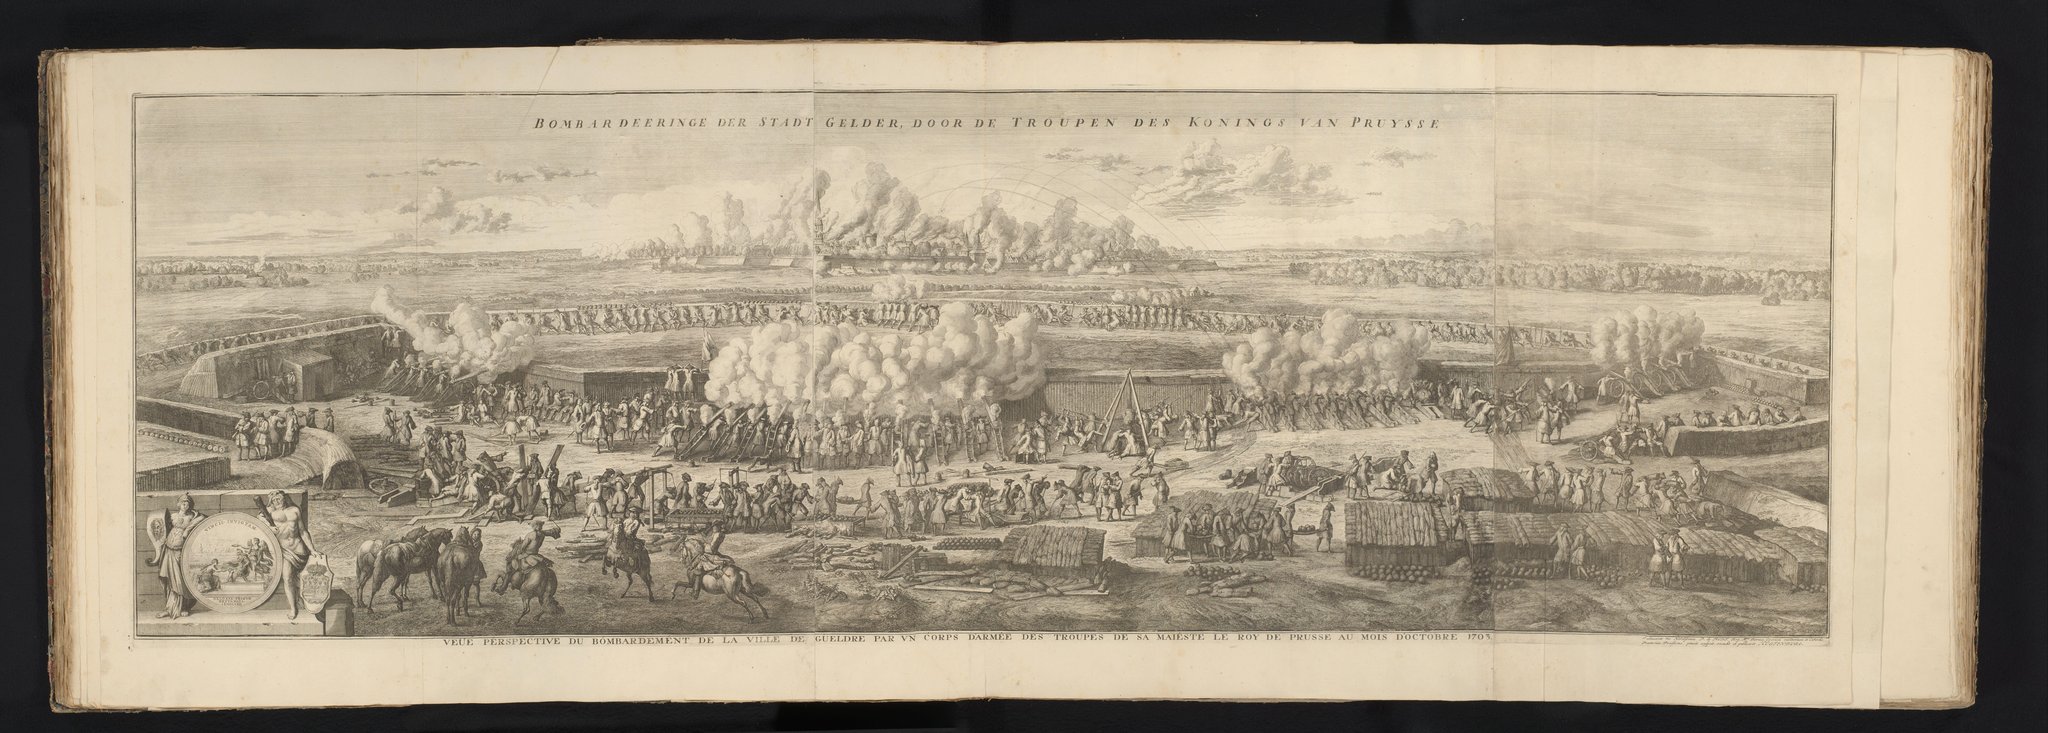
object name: print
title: Bombardement van Geldern, 1703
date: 1727-1729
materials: paper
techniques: engraving, etching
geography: the hague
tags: johan willem friso (prins van oranje-nassau), john churchill (1e hertog van marlborough), siege, position war, projectiles, explosives, etc., bombardment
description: Het bombardement van Geldern door de Pruisische troepen onder generaal Lotthum in de maand oktober 1703. Zeer brede voorstelling (gedrukt van drie platen) vanuit het kamp van de belegeraars waar kanonskogels worden gefabriceerd en afgeschoten. Genummerd rechtsonder: Tom. II. No. 7. Illustratie in het tweede deel van : [Jean] du Mont, Oorlogskundige beschryving van de veldslagen en belegeringen, der drie ... wydvermaarde krygsoversten... den Prins Eugenius van Savoye, den ... Hertog van Marlborough, en den Prins van Oranje en Nassau-Vriesland, in de editie van 1729. Dit tweede deel is hoofdzakelijk gewijd aan de daden van de hertog van Marlborough en prins Johan Willem Friso.